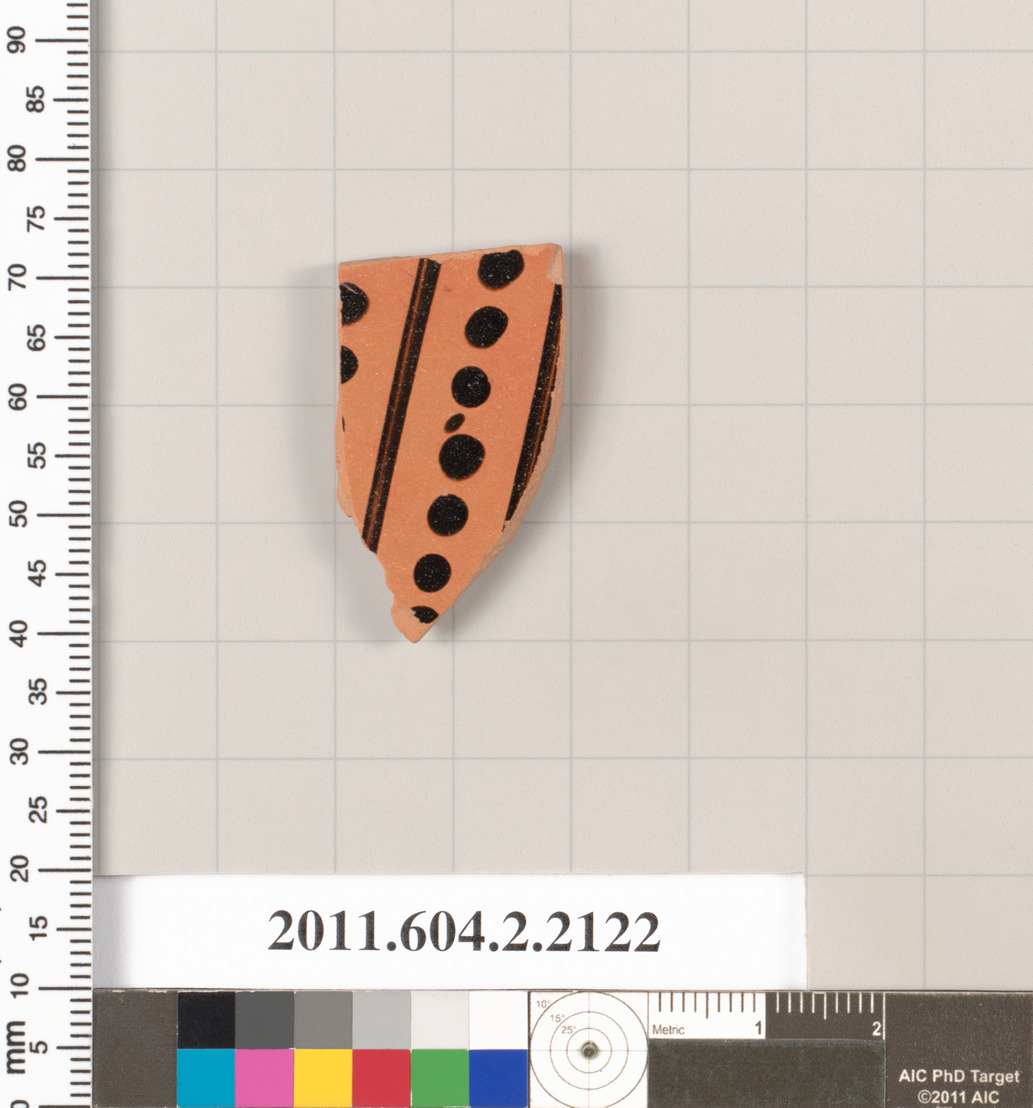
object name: pot fragment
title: Terracotta fragment of a pot; glazed on the inside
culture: greek, attic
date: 460-440 BCE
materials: terracotta